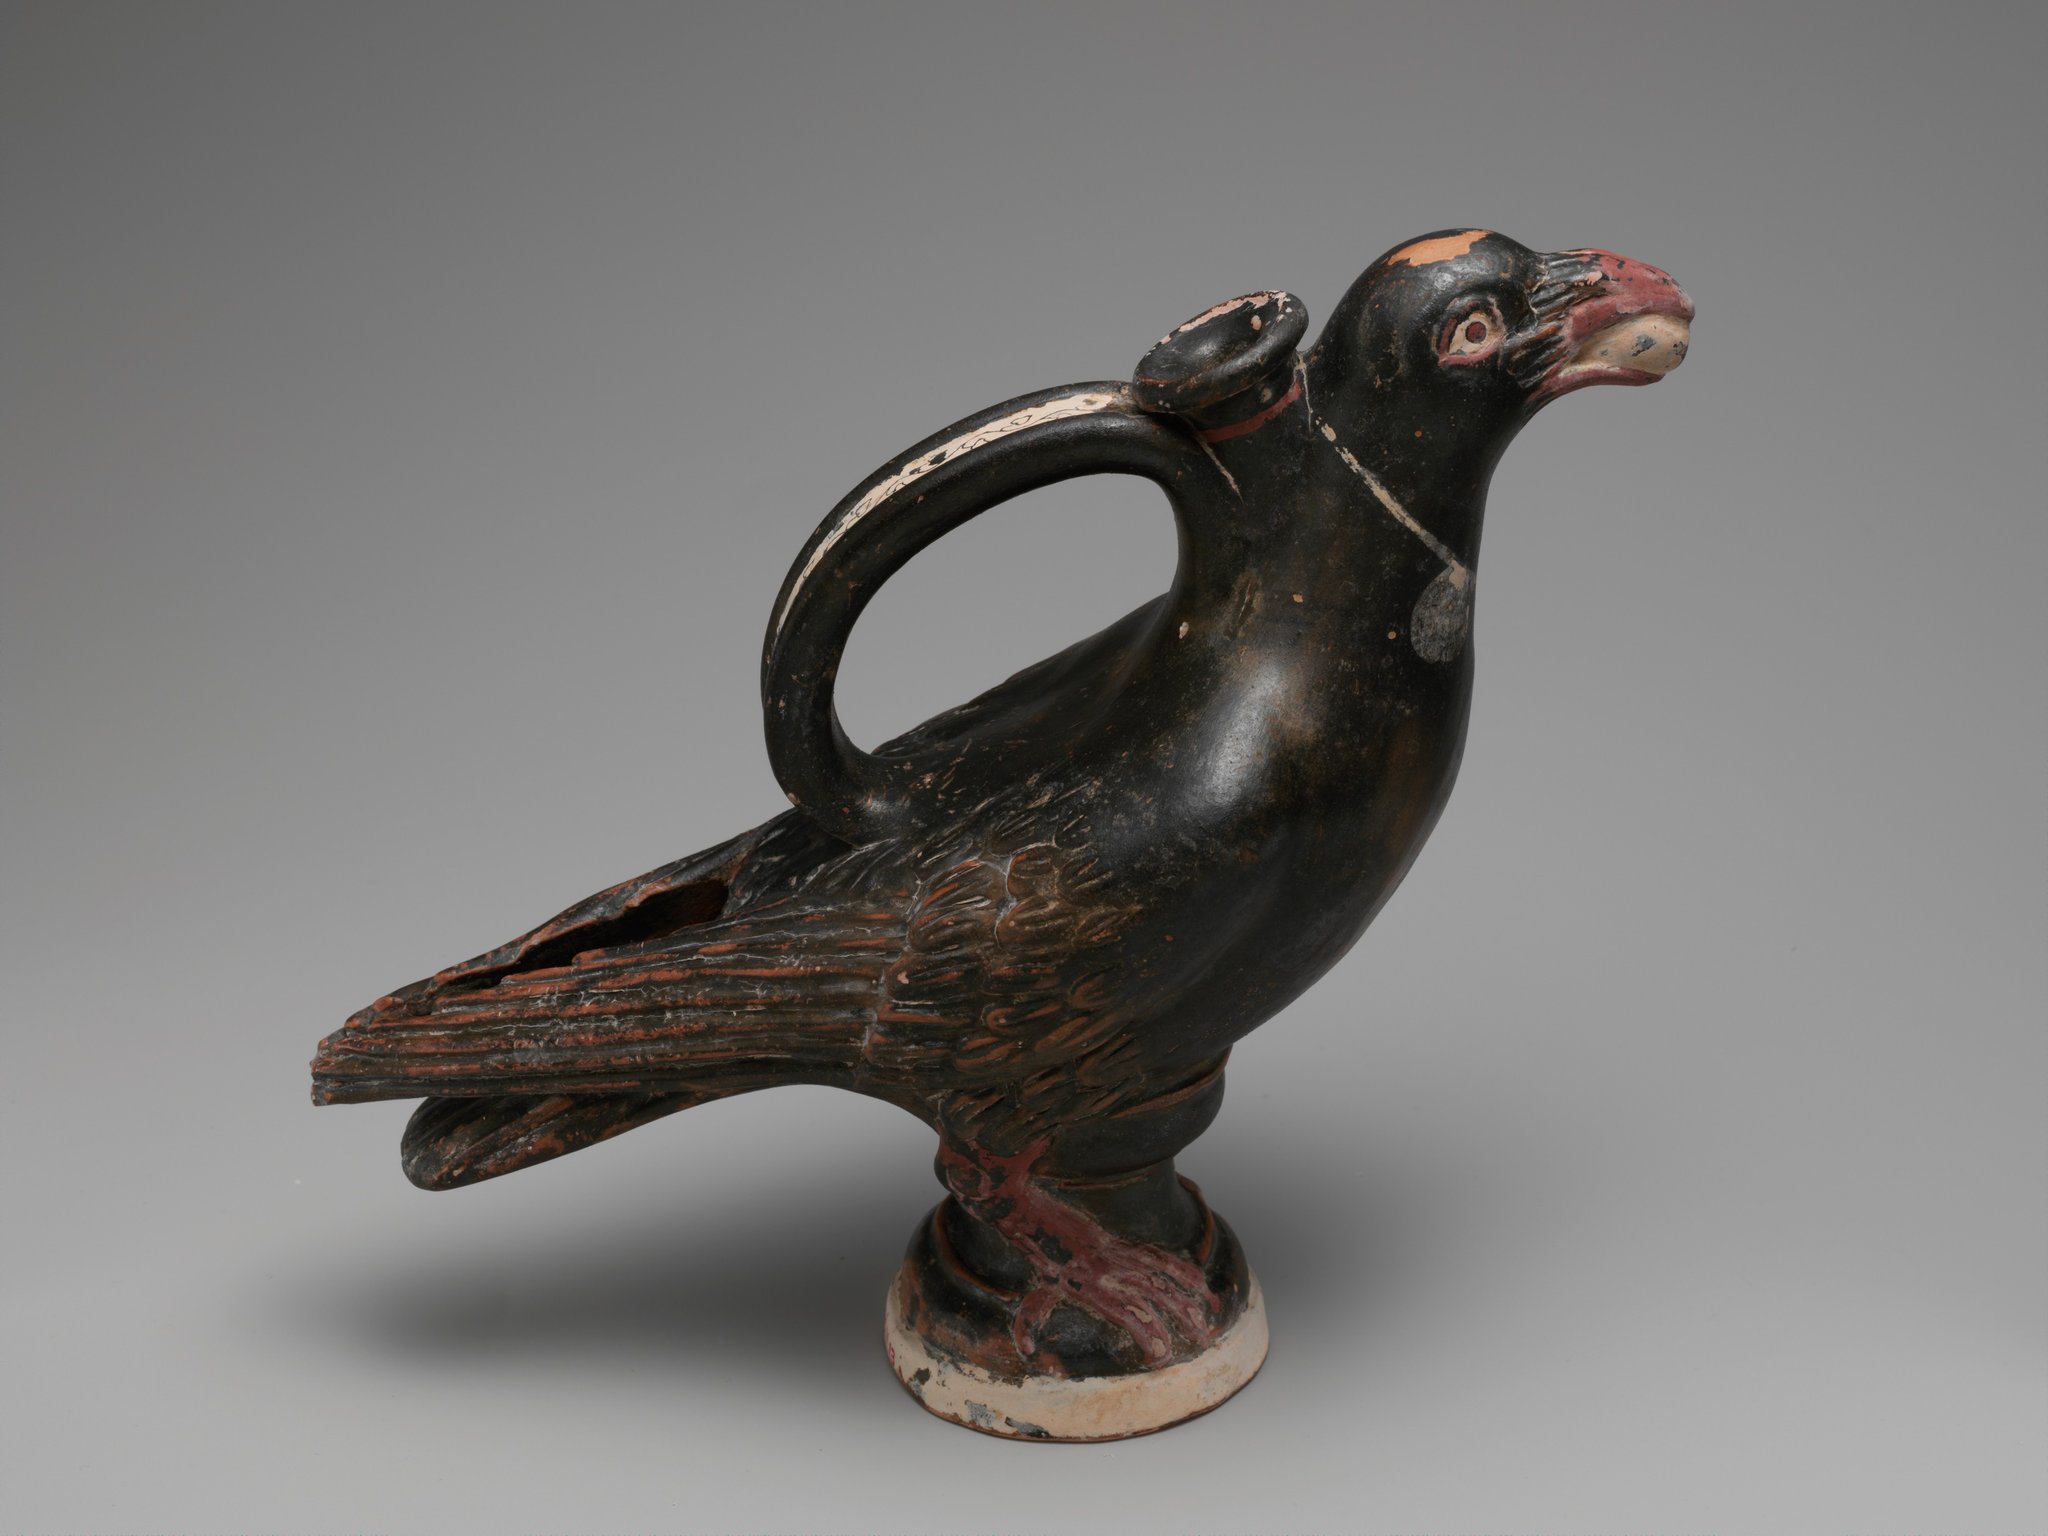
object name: askos in the form of a jackdaw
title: Terracotta askos (flask) in the form of a jackdaw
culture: etruscan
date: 400-301 BCE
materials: terracotta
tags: crowd